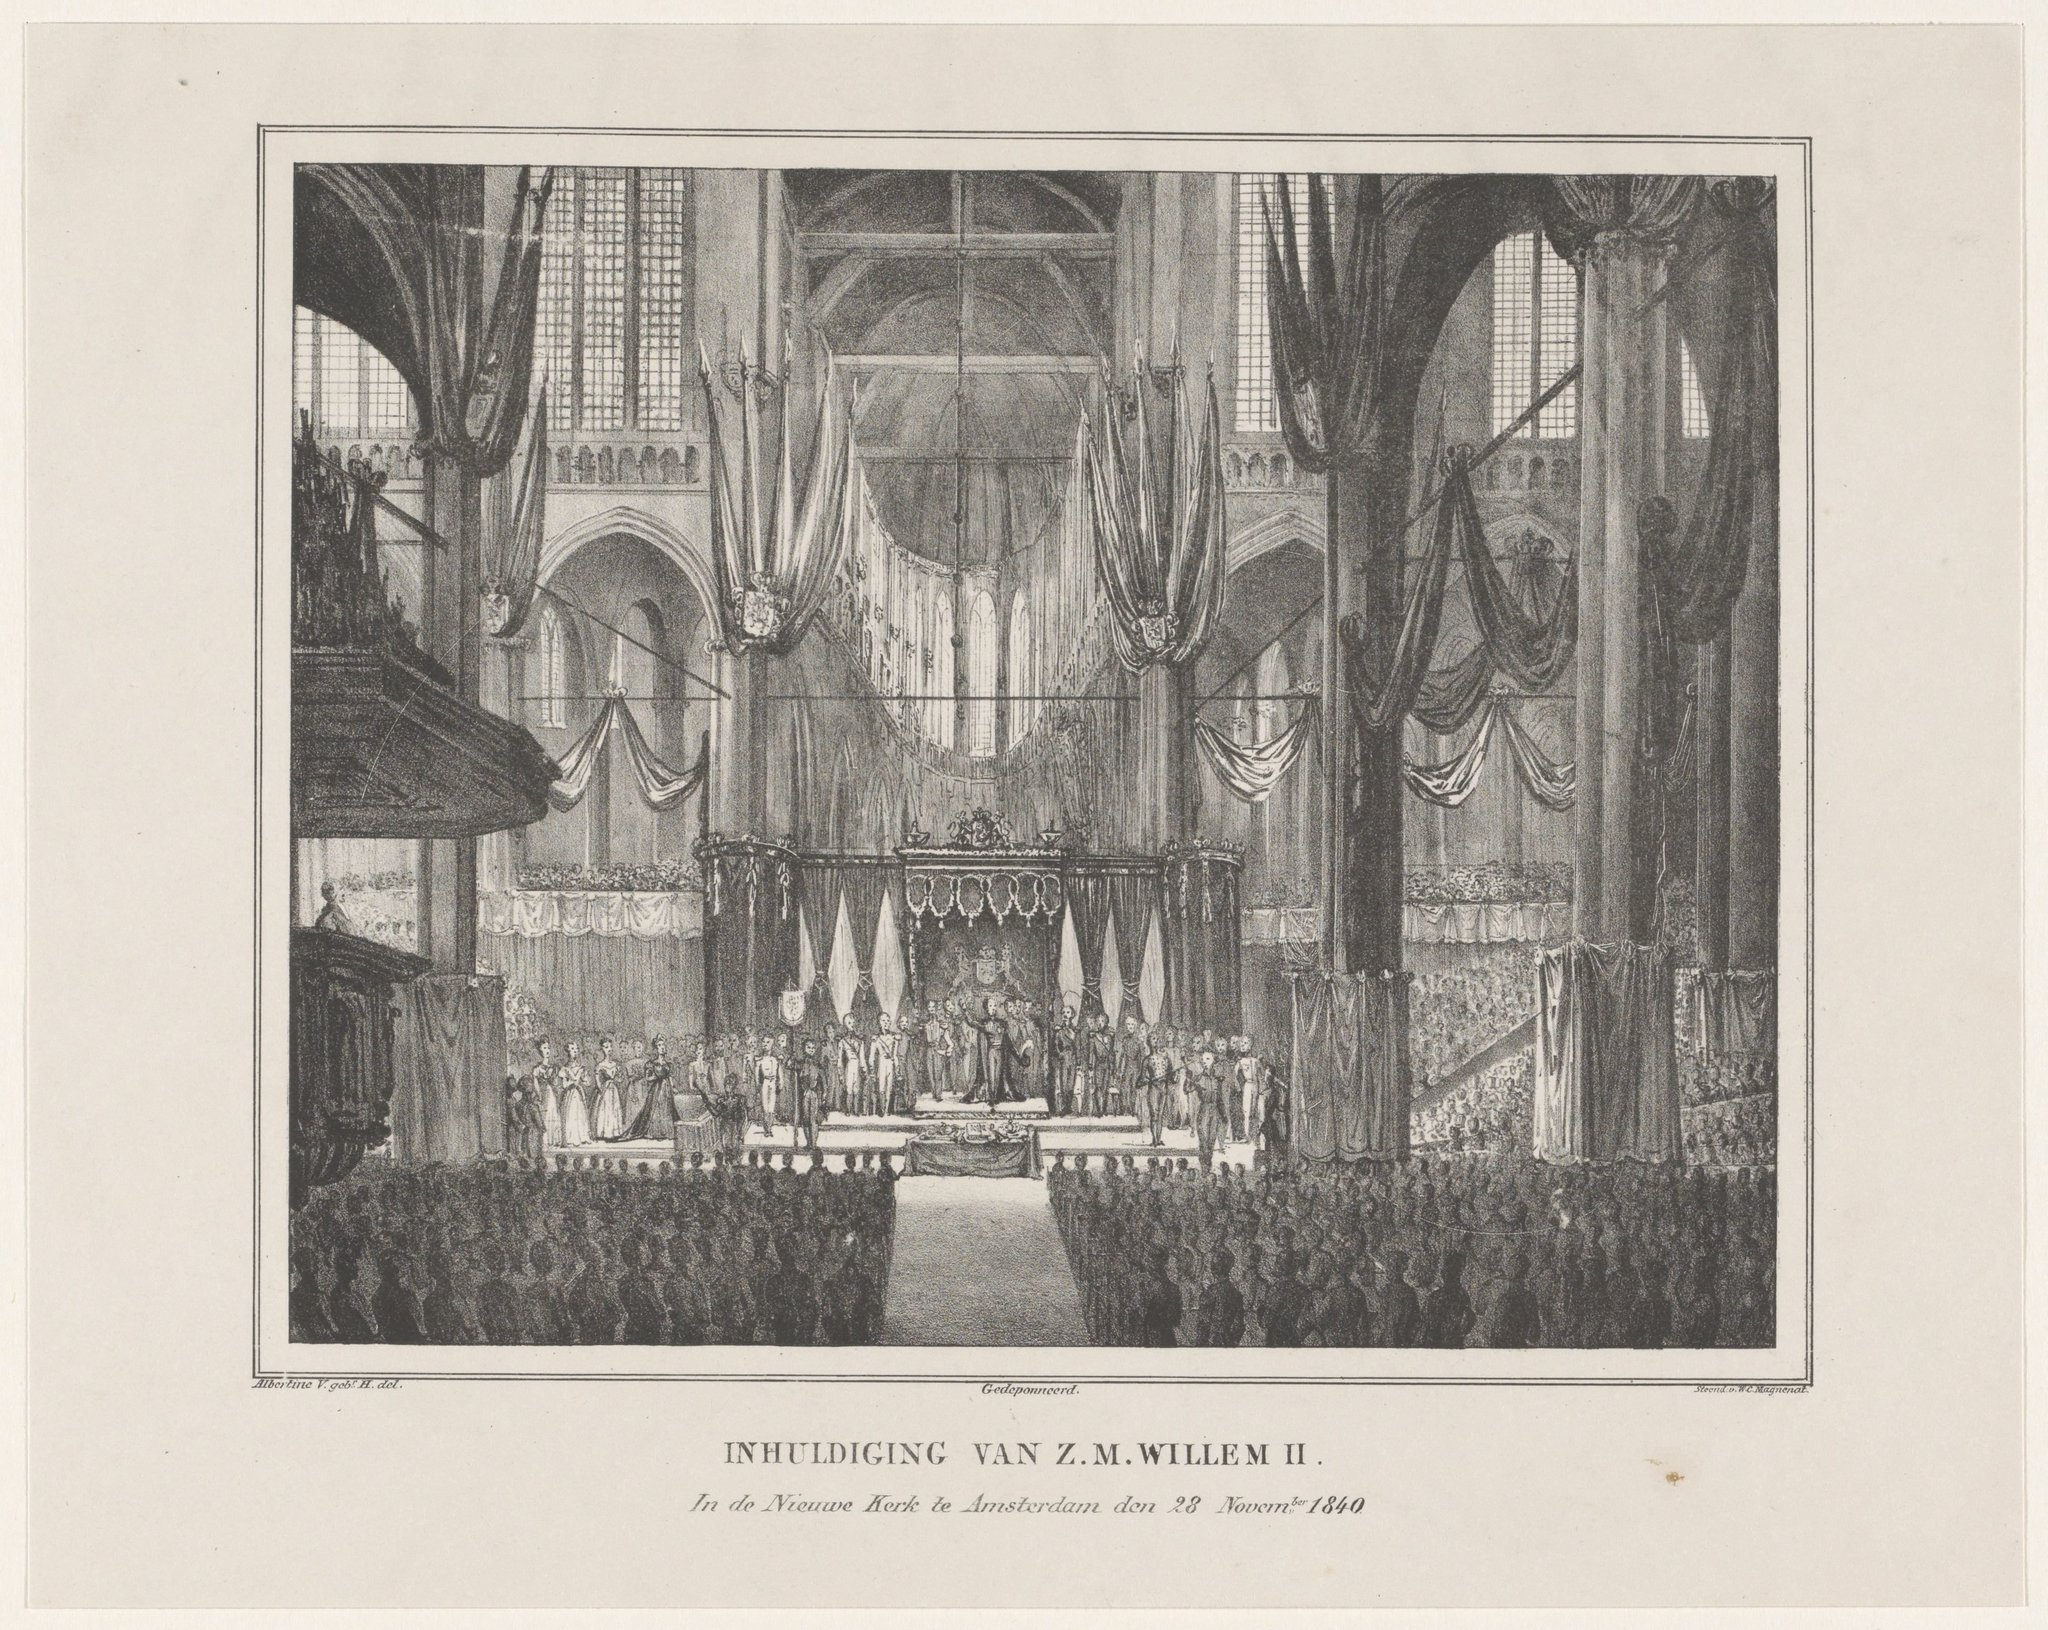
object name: print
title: Inhuldiging van Z.M. Willem II. In de Nieuwe Kerk te Amsterdam den 28 November 1840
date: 1840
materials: paper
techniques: lithograph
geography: netherlands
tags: william ii of the netherlands, new ruler taking the oath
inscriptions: collector's mark: Lugt 2228, : ‘Gedeponneerd’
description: Inhuldiging van koning Willem II in de Nieuwe Kerk te Amsterdam op 28 november 1840. De koning legt staande voor de troon de eed af. Zie ook de pendant.